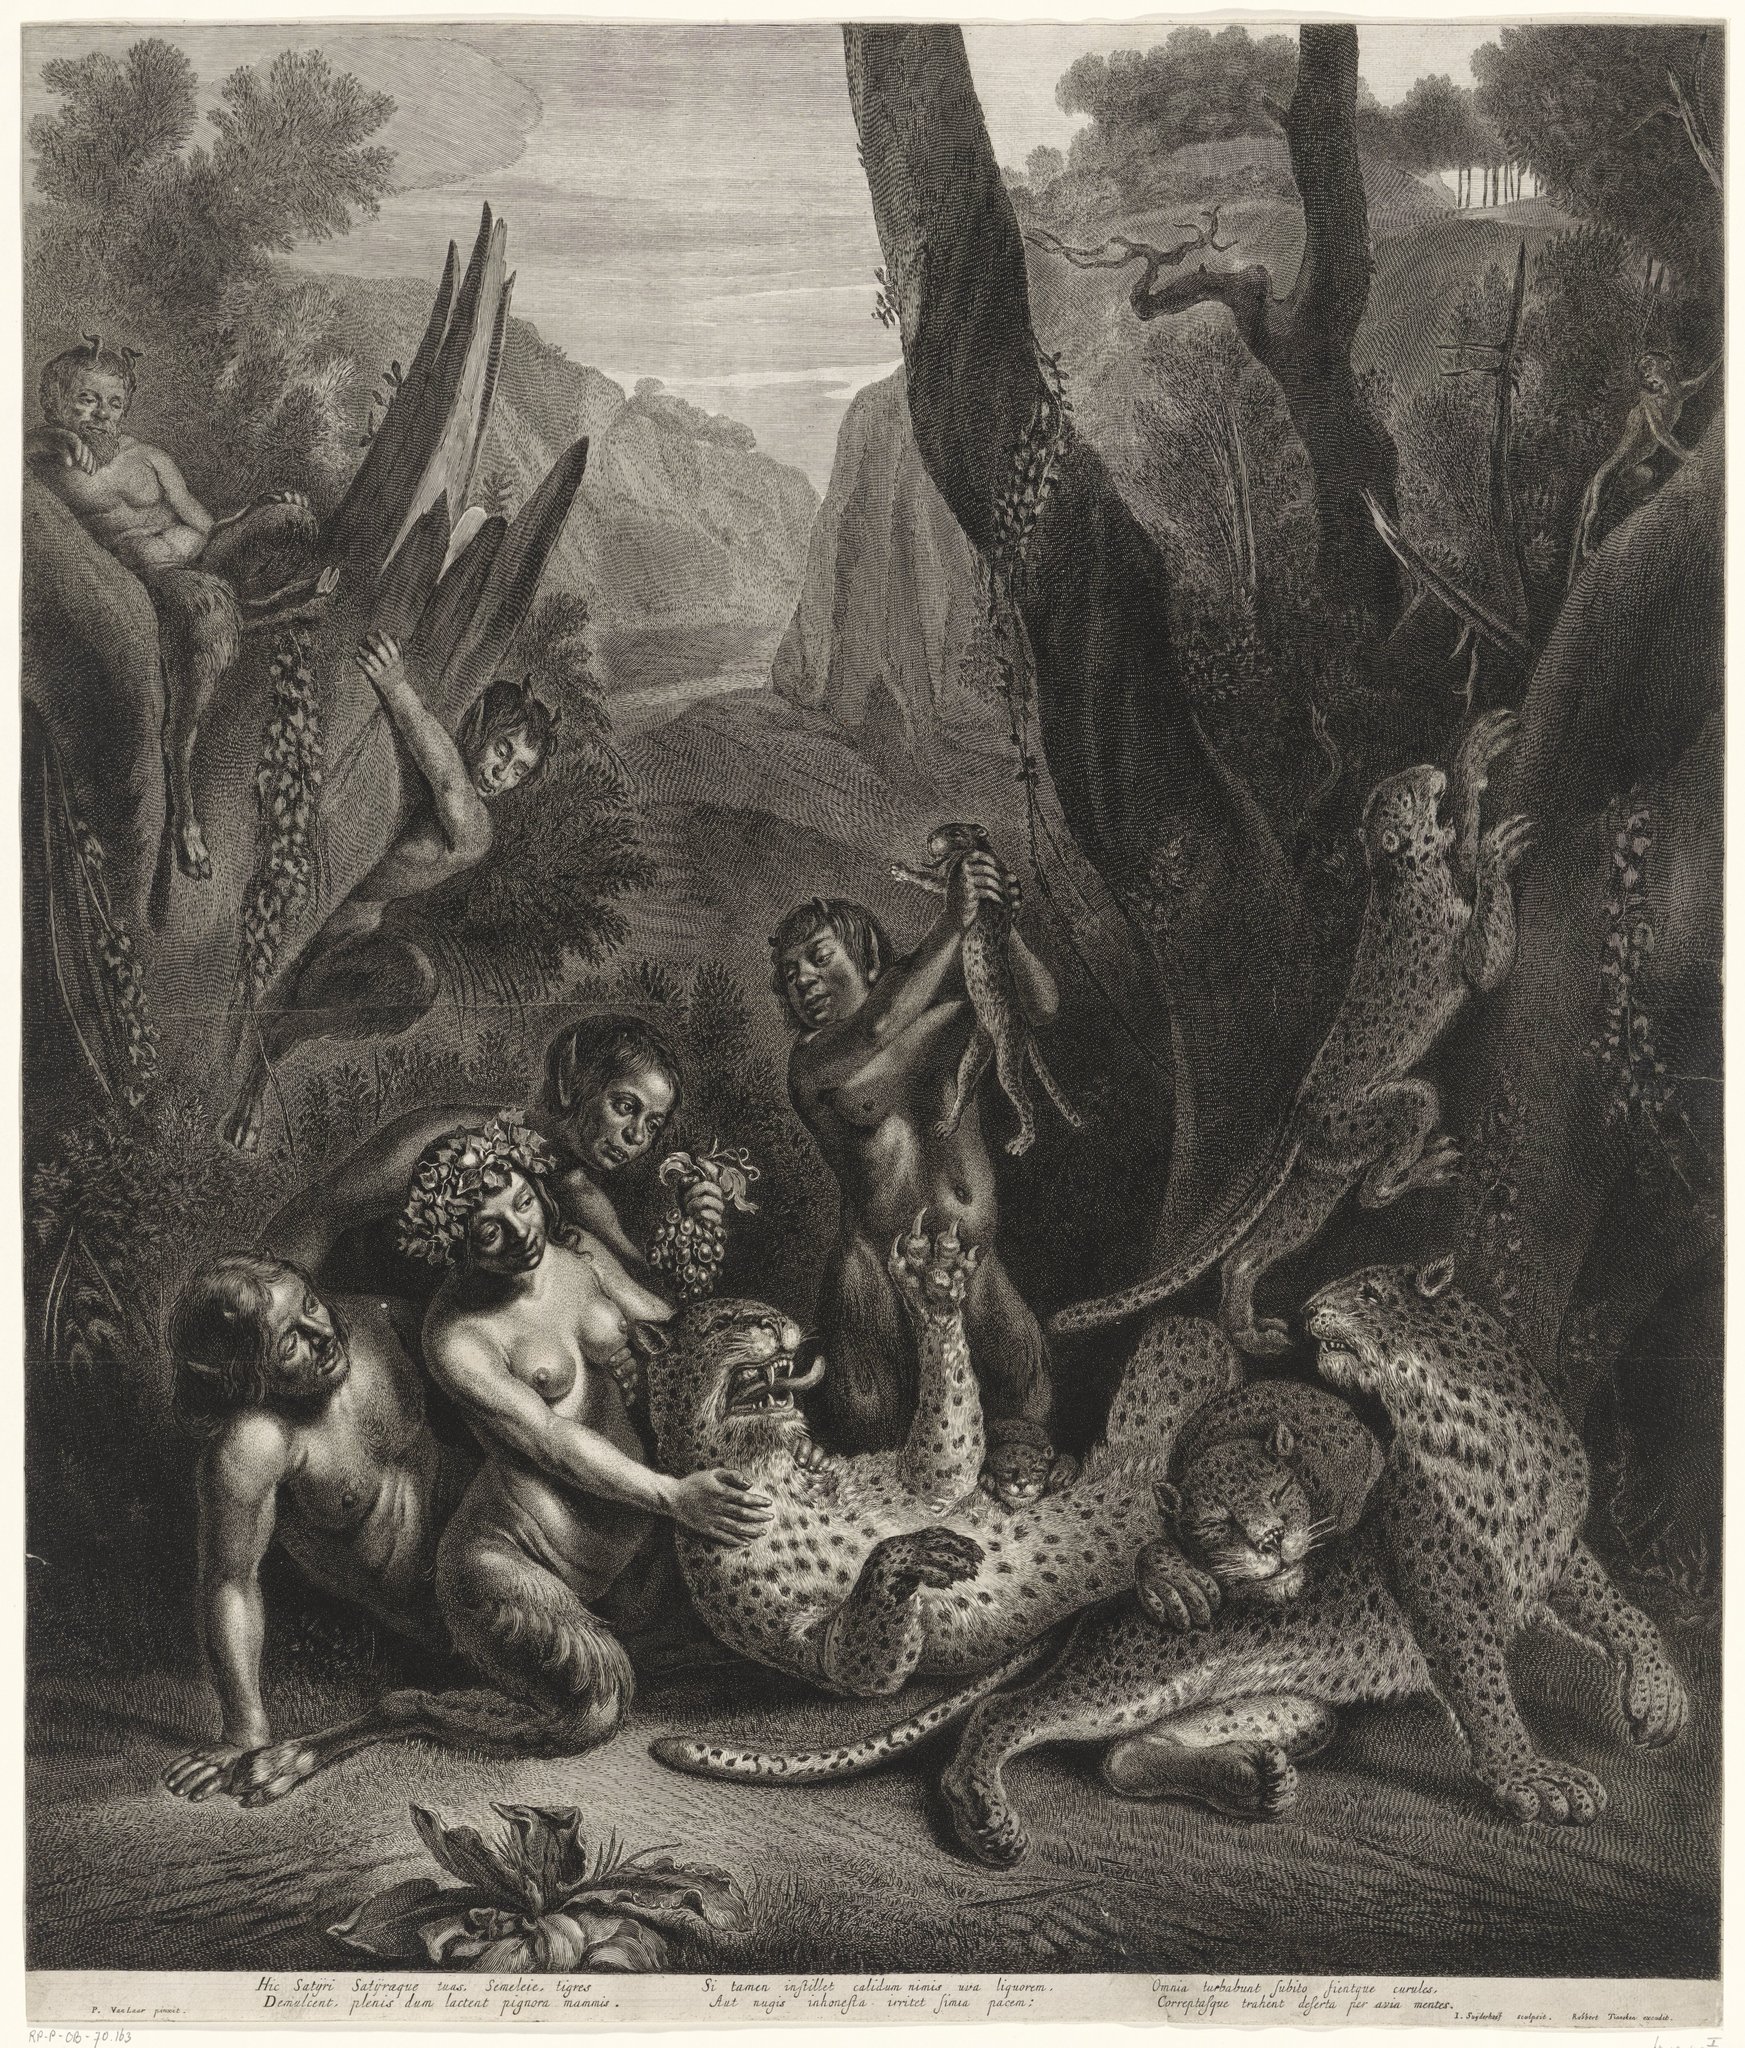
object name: print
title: Saterfamilie spelend met luipaarden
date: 1645-1669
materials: paper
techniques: engraving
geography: haarlem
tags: beasts of prey, predatory animals: leopard, satyr(s) (in general)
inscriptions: collector's mark: Lugt 240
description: Een saterfamilie speelt met luipaarden. Een mannelijke sater tilt een jong luipaard op en een vrouwelijke sater aait een groot luipaard. Een andere sater houdt een tros druiven in de hand.